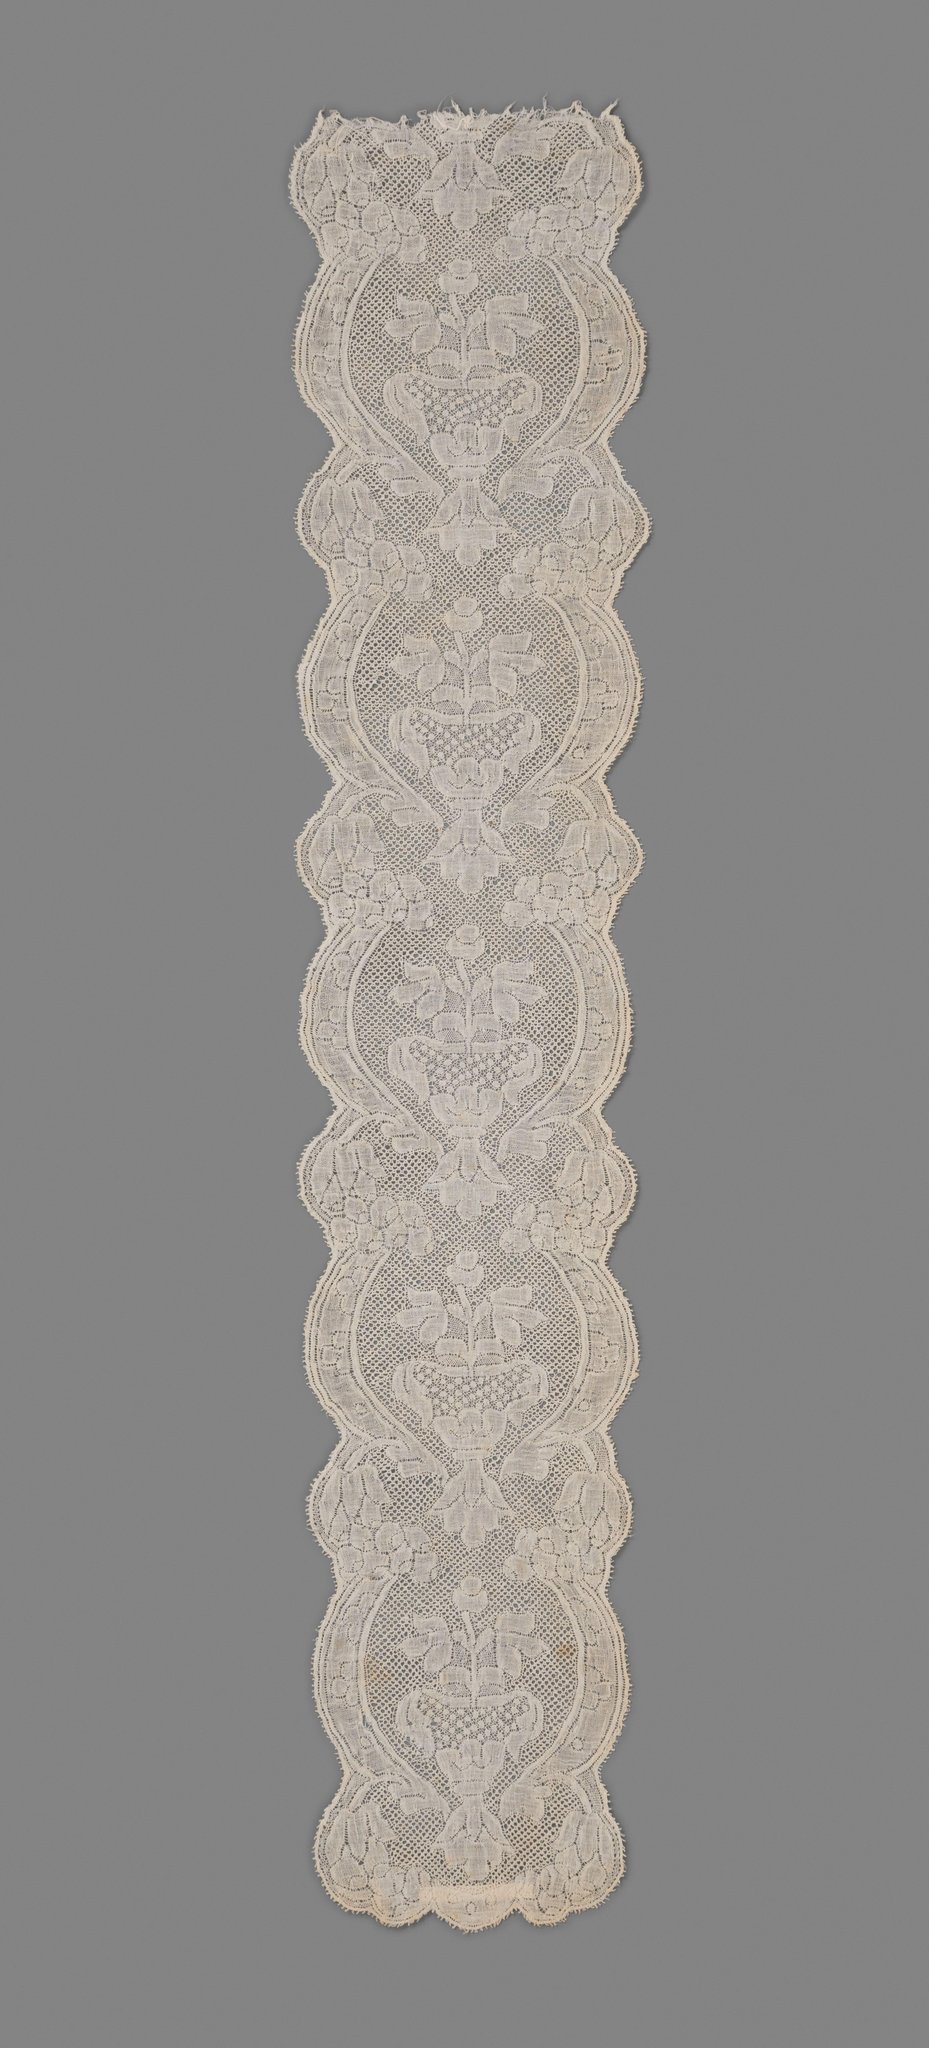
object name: womenswear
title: Mutsenslip van Binchekant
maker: Anonymous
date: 1750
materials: linen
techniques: lace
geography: binche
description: Barbes van kloskant, Binche. Textuur:fond à cinq trous. Ornament met gerloden ajourrand en van linnenslag en schaars netslag. Siersteken van spinnen. Patroon: de vierkante uiteinden zijn geschulpt. herhaling van vijf boven elkaar geplaatste bloempotten binnen twee boogvormige omlijstingen, die onder een boven met afhangende vruchtentros verbonden zijn.